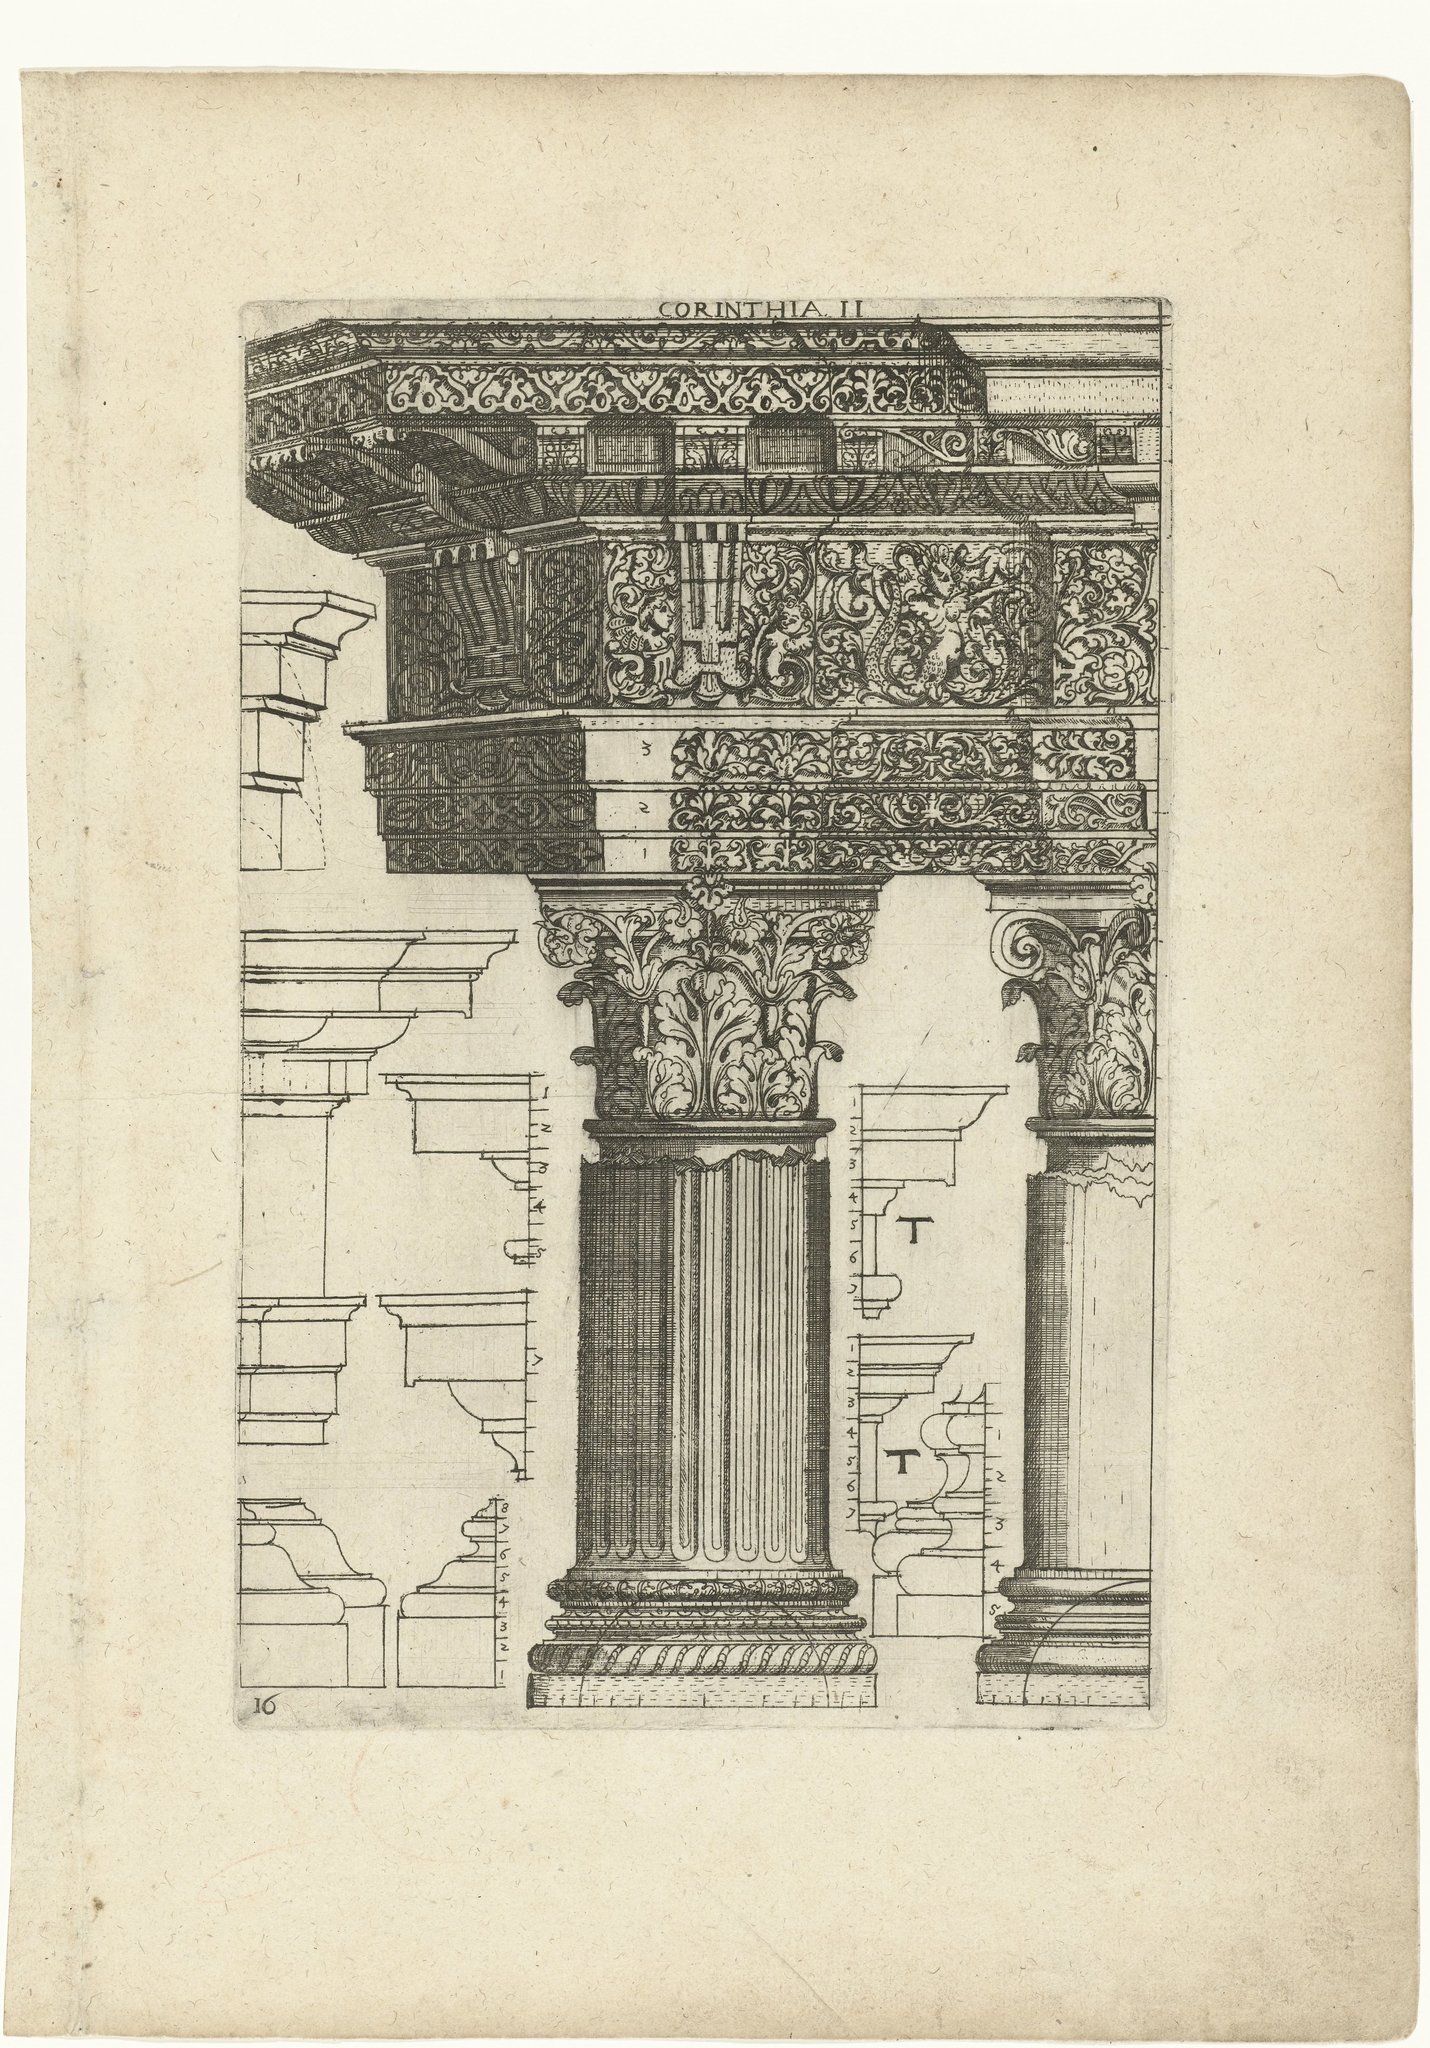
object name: ornament print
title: Korintisch hoofdgestel, twee kapitelen, zuilschachten en voetstukken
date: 1610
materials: paper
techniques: etching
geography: germany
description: Op het blad zijn doorsneden van verschillende details te zien, waarvan twee zijn gemerkt met een T. Blad 16 uit serie van titelblad en 28 bladen.